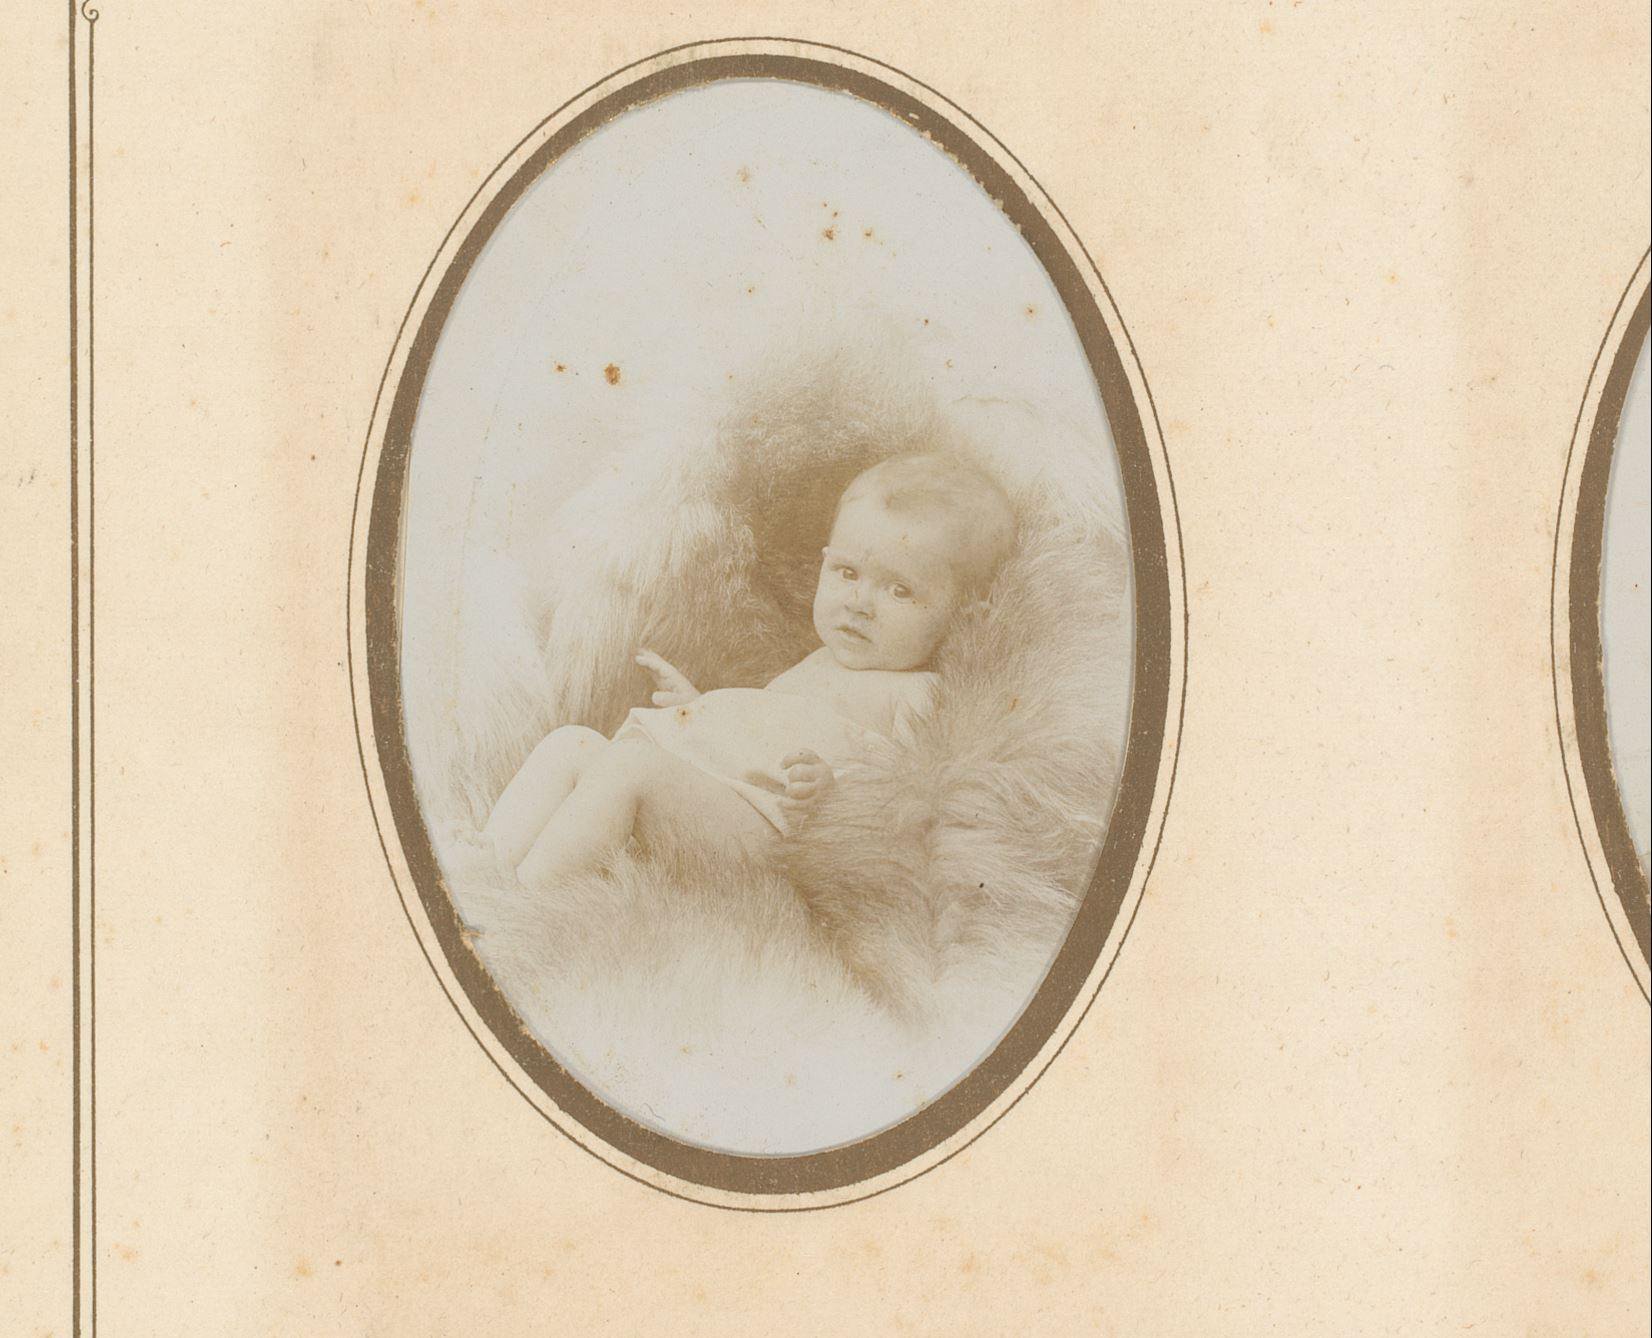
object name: photograph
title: Portret van een peuter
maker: j.w. wentzel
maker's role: fotograaf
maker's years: 1855-1930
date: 1901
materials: cardboard, photographic support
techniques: collodion silver print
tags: toddler, historical persons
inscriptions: inscription: ‘J.W. Wentzel/ (...)/ Amersfoort/ Langestraat F 12/ (...)’, annotation: ‘5 [...] 1901’